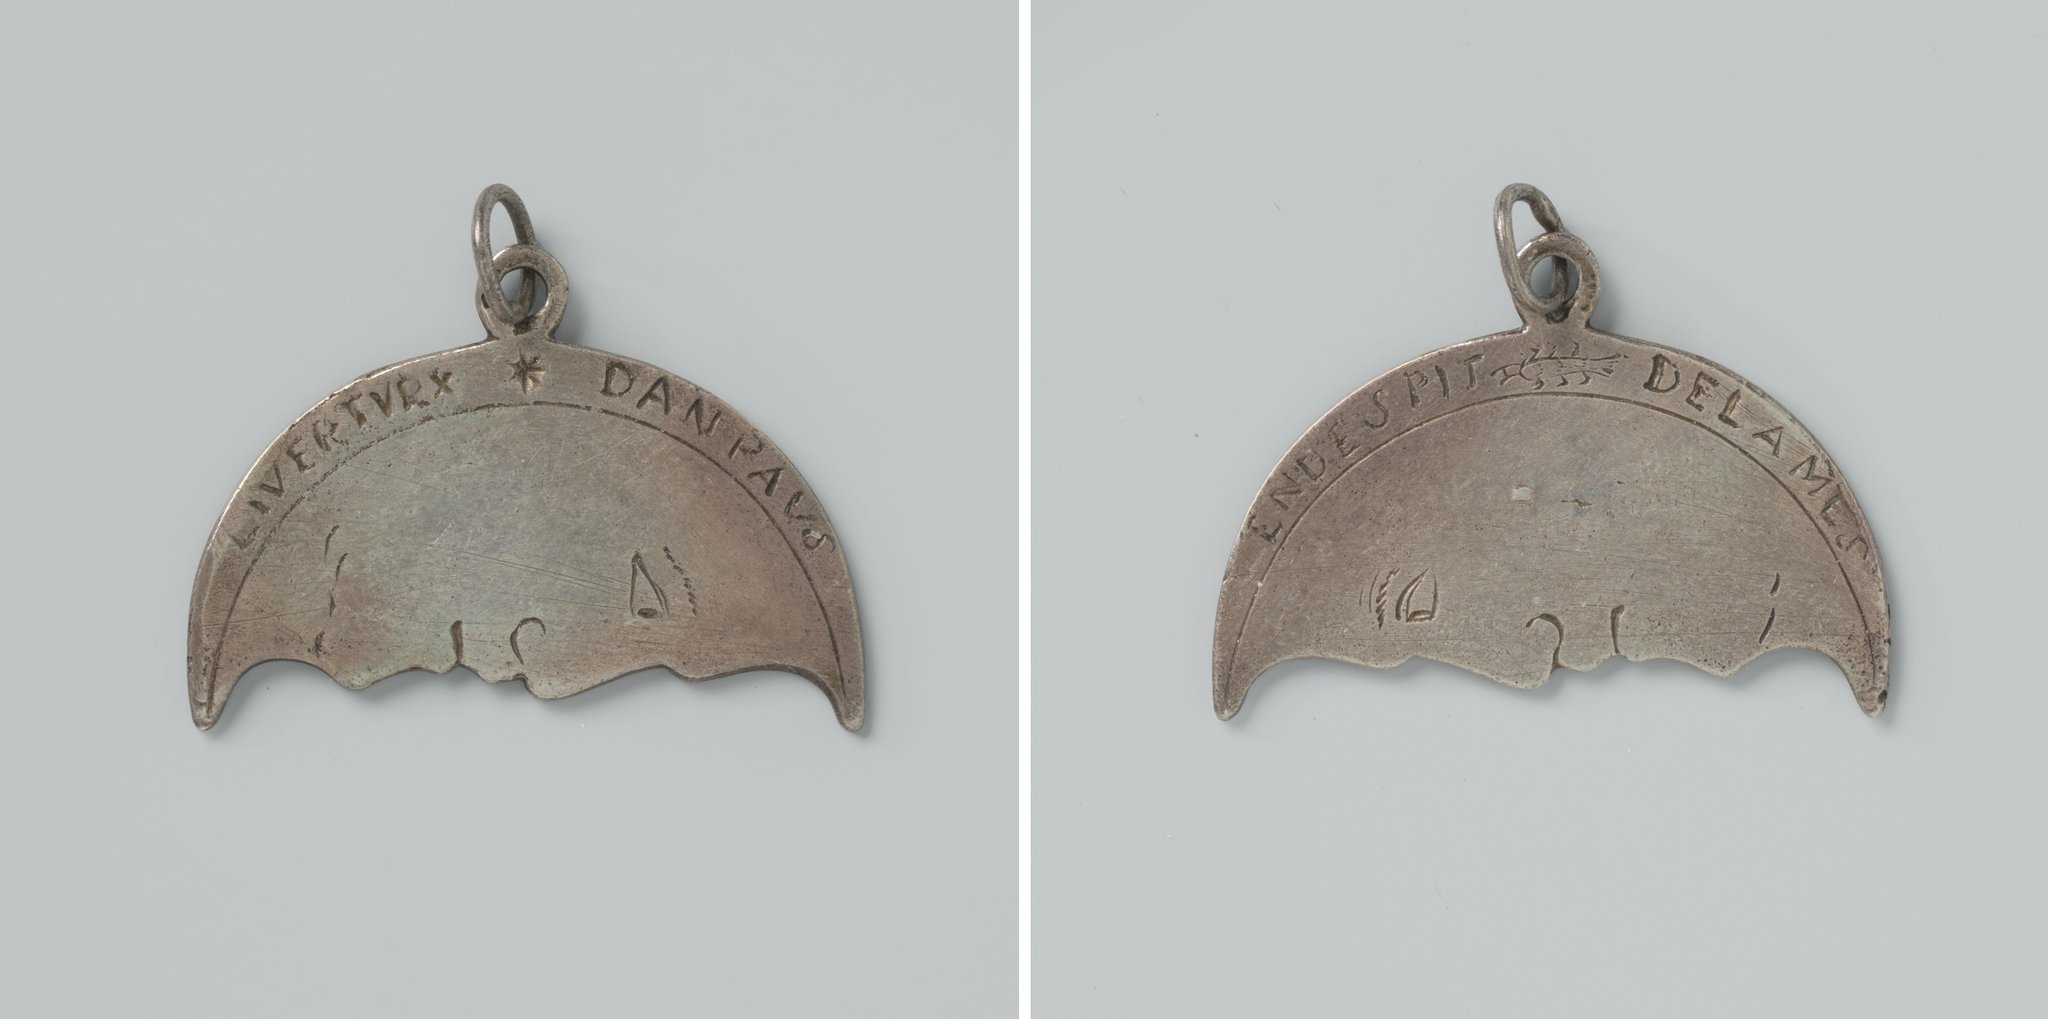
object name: beggar's medal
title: Geuzenpenning (halve maan)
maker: Anonymous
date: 1574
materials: silver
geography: leiden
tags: verbond der edelen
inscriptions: circumscription: ‘EN DESPIT [kreeftje] DE LA MES’, circumscription: ‘LIVER TVRX * DAN PAVS’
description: Geuzenpenning in de vorm van een halve maan, met aan beide zijden ingegraveerd een gezicht en een tekst, met draagoog aan lange zijde waarin een draagring